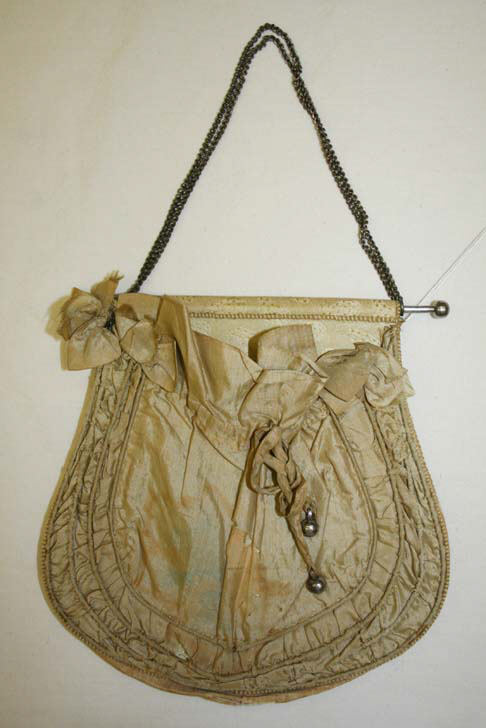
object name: purse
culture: american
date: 1830-1839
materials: silk